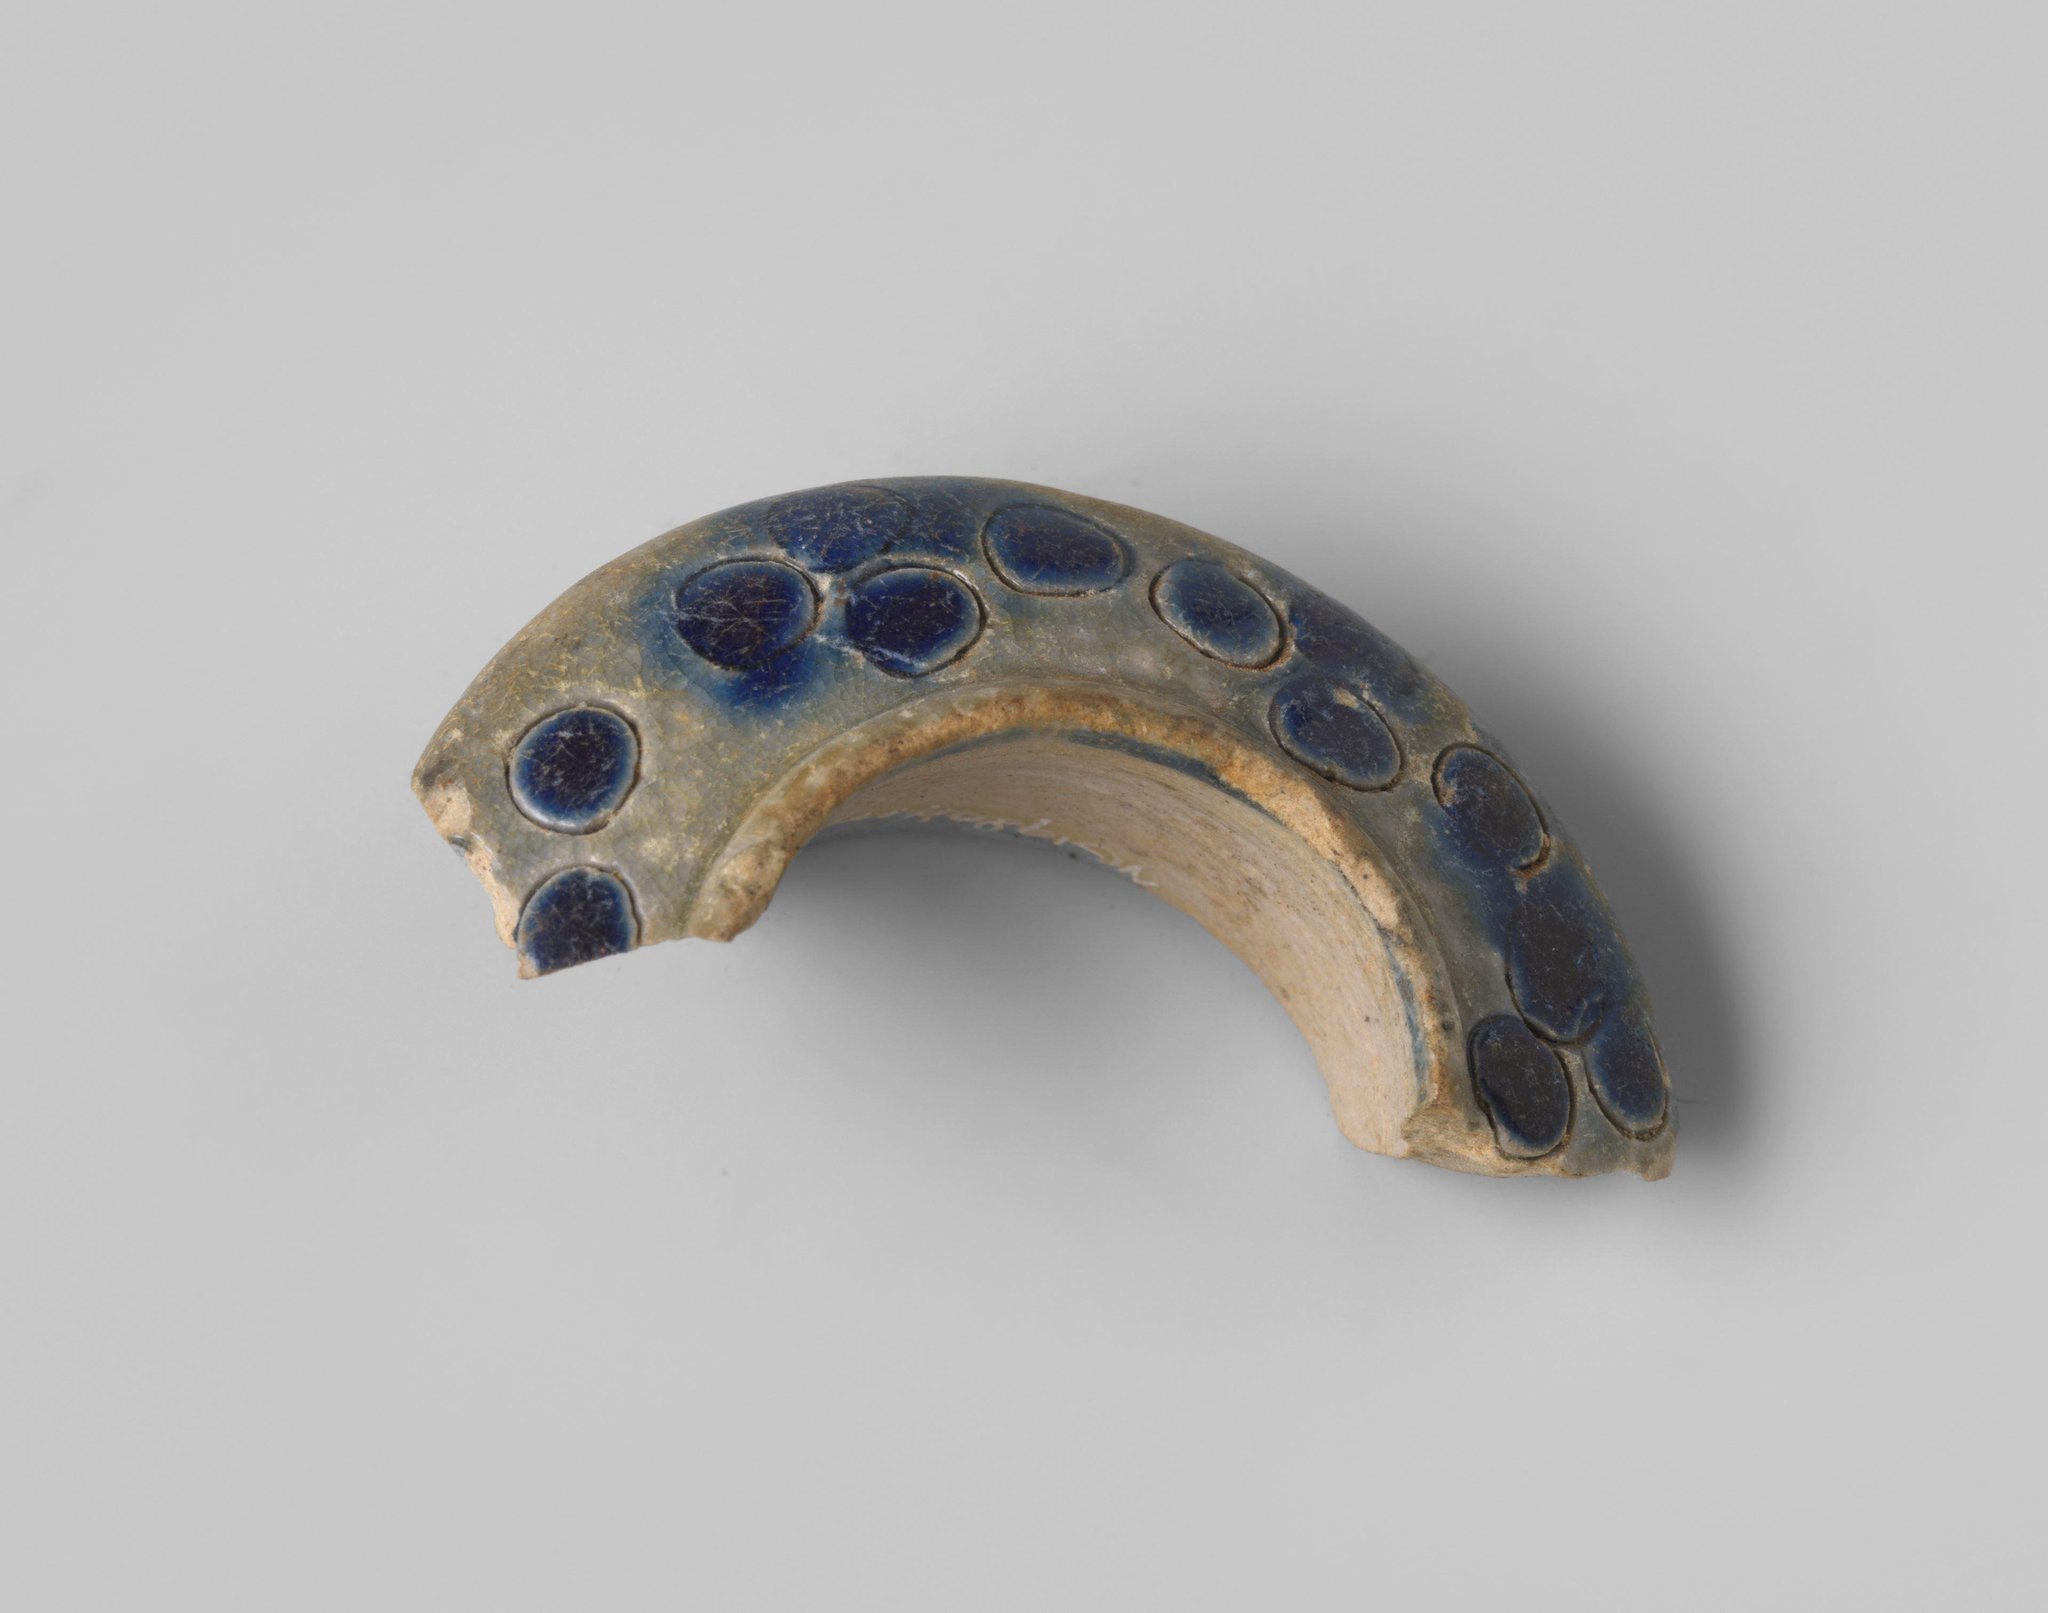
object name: inkwell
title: Hals van een inktpot uit het wrak van de Oost-Indiëvaarder Hollandia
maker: Anonymous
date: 1700-1743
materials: earthenware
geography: netherlands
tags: verenigde oostindische compagnie, hollandia (schip), annet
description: Inkwell, neck; fragm of top, straight, circular body, plain exterior, with oblique overhanging rim, raised inner border, engraved and blue-painted decoration.